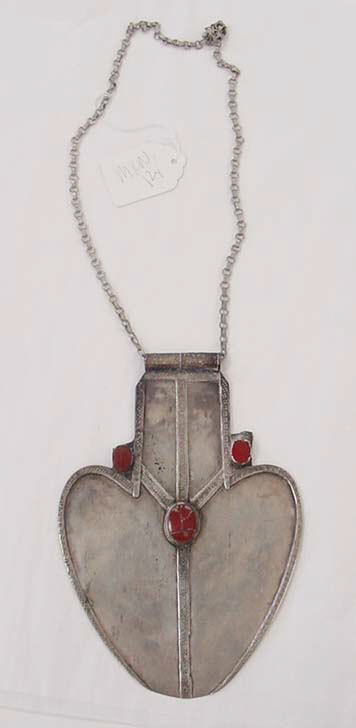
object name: necklace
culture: moroccan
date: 1801-1900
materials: gemstone, metal